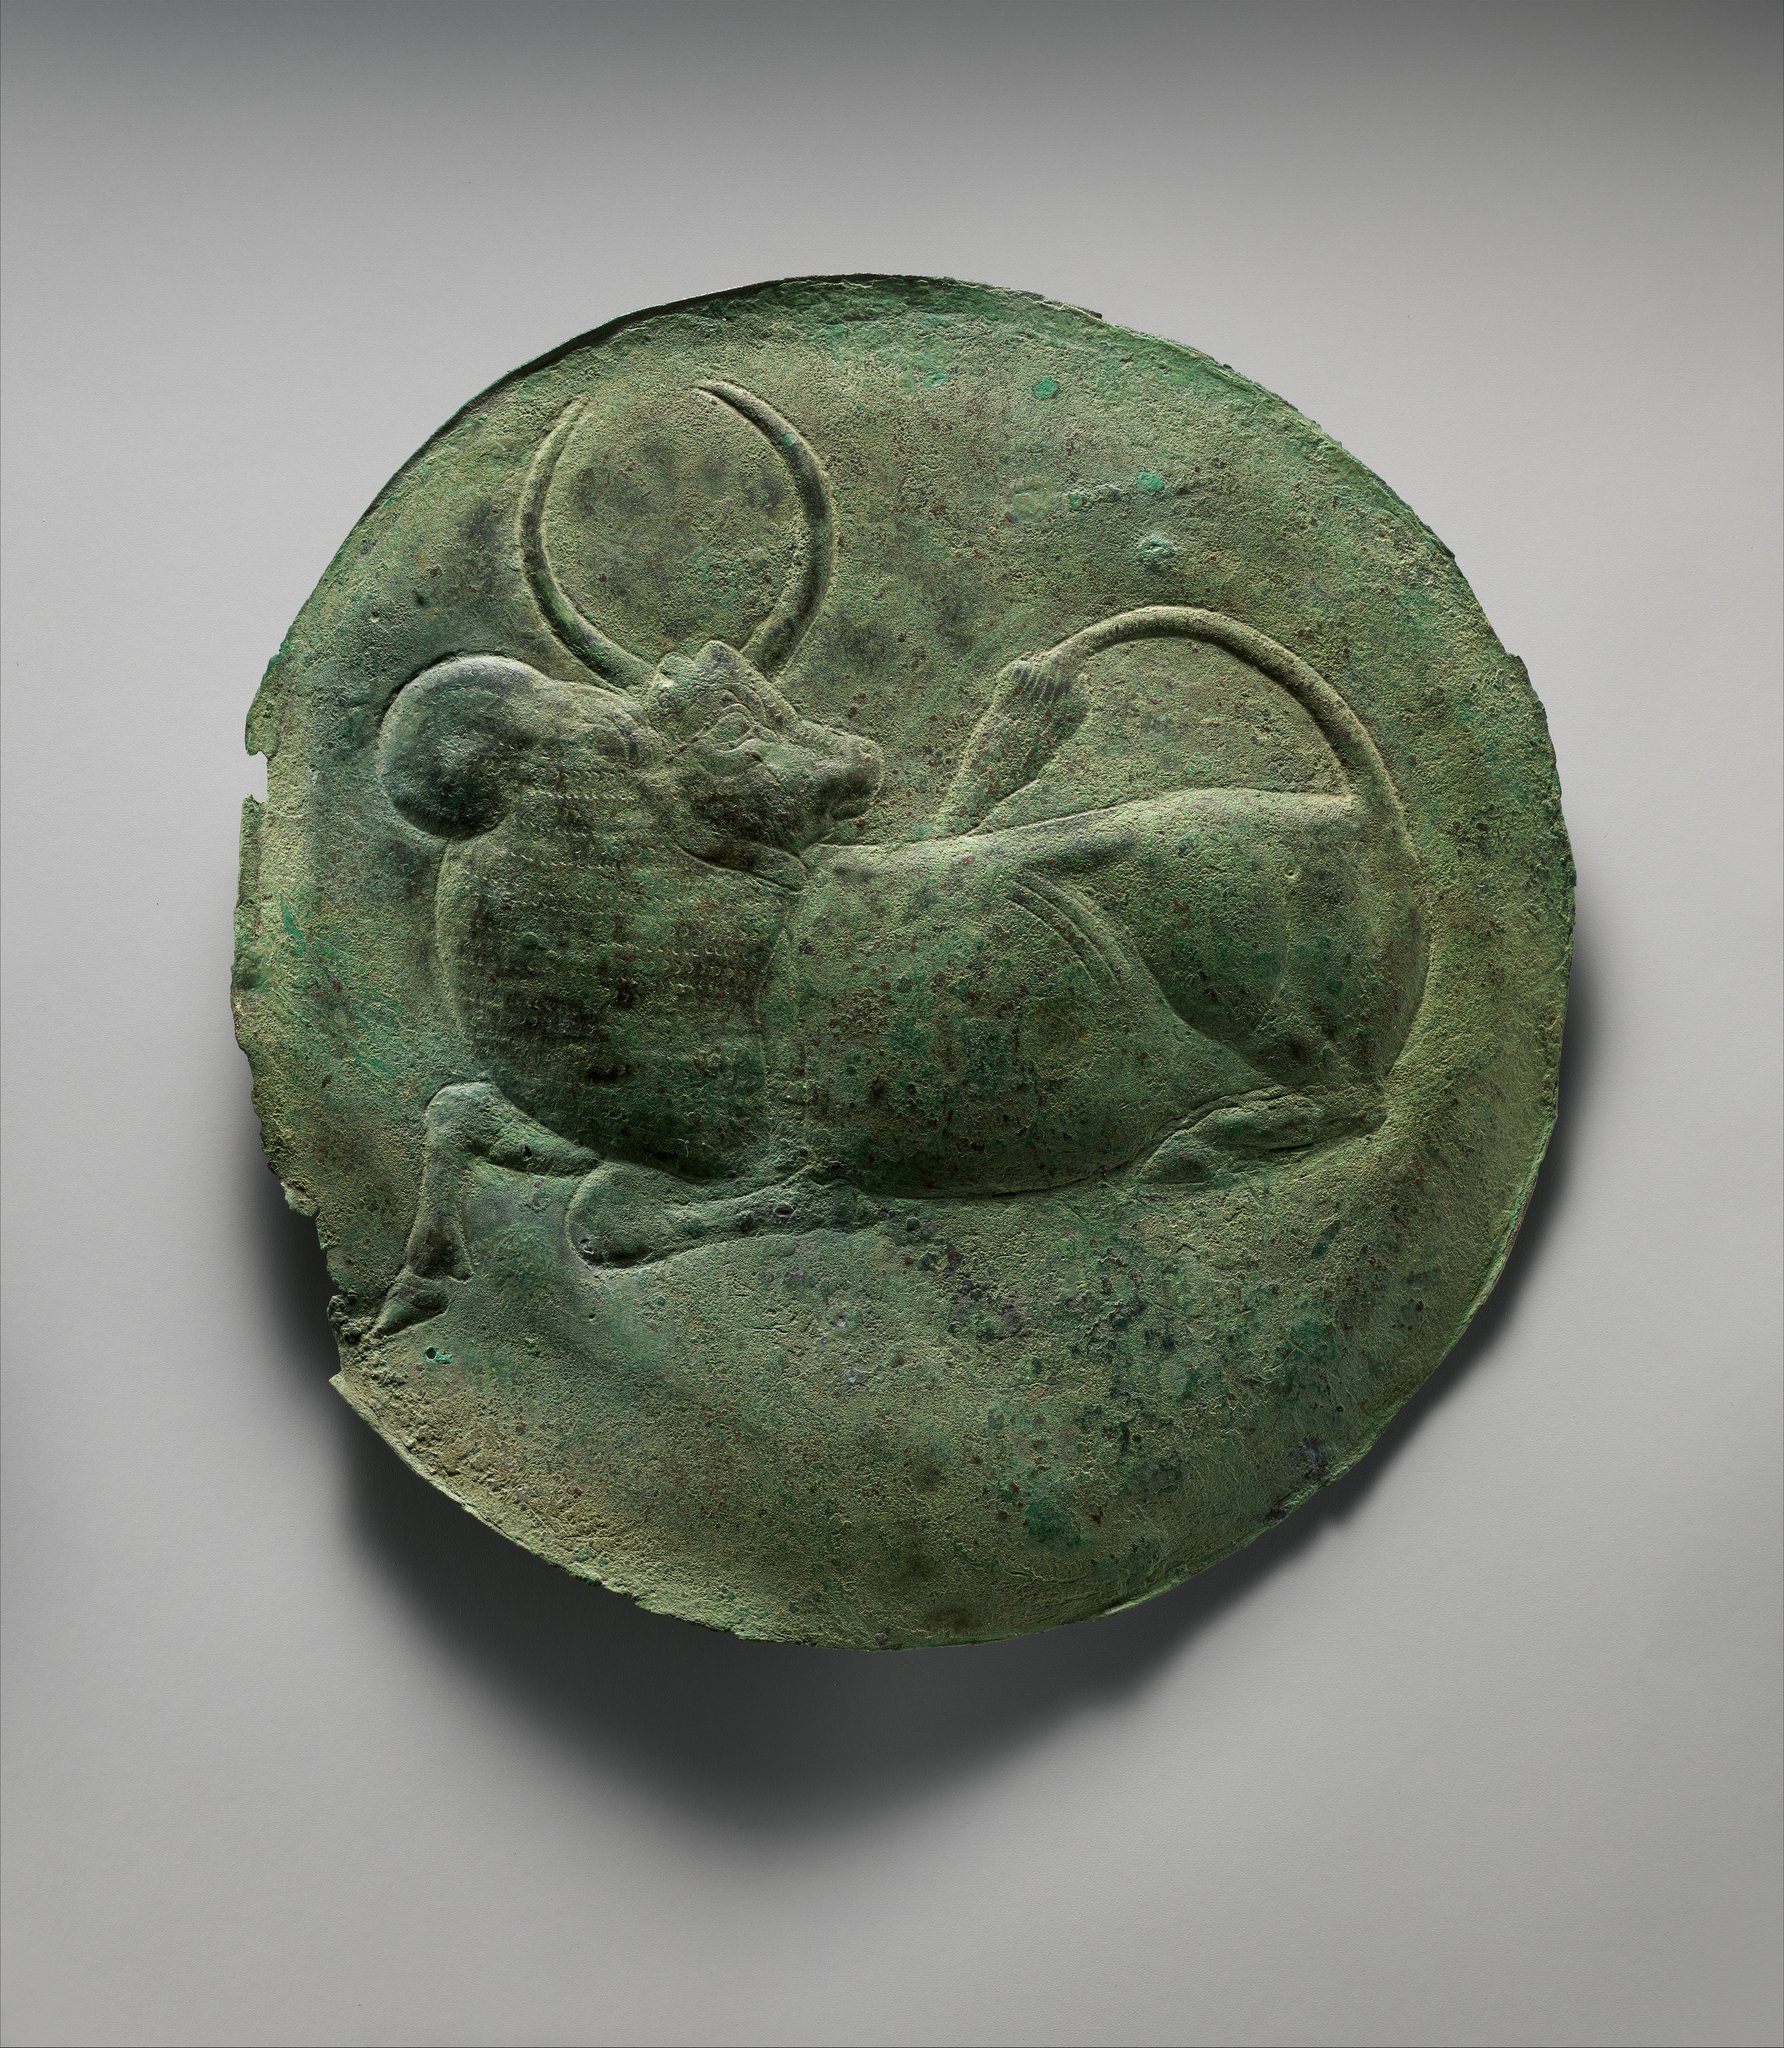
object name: plate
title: Plate with reclining zebu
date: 2333-1668 BCE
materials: copper alloy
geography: iran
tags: animals